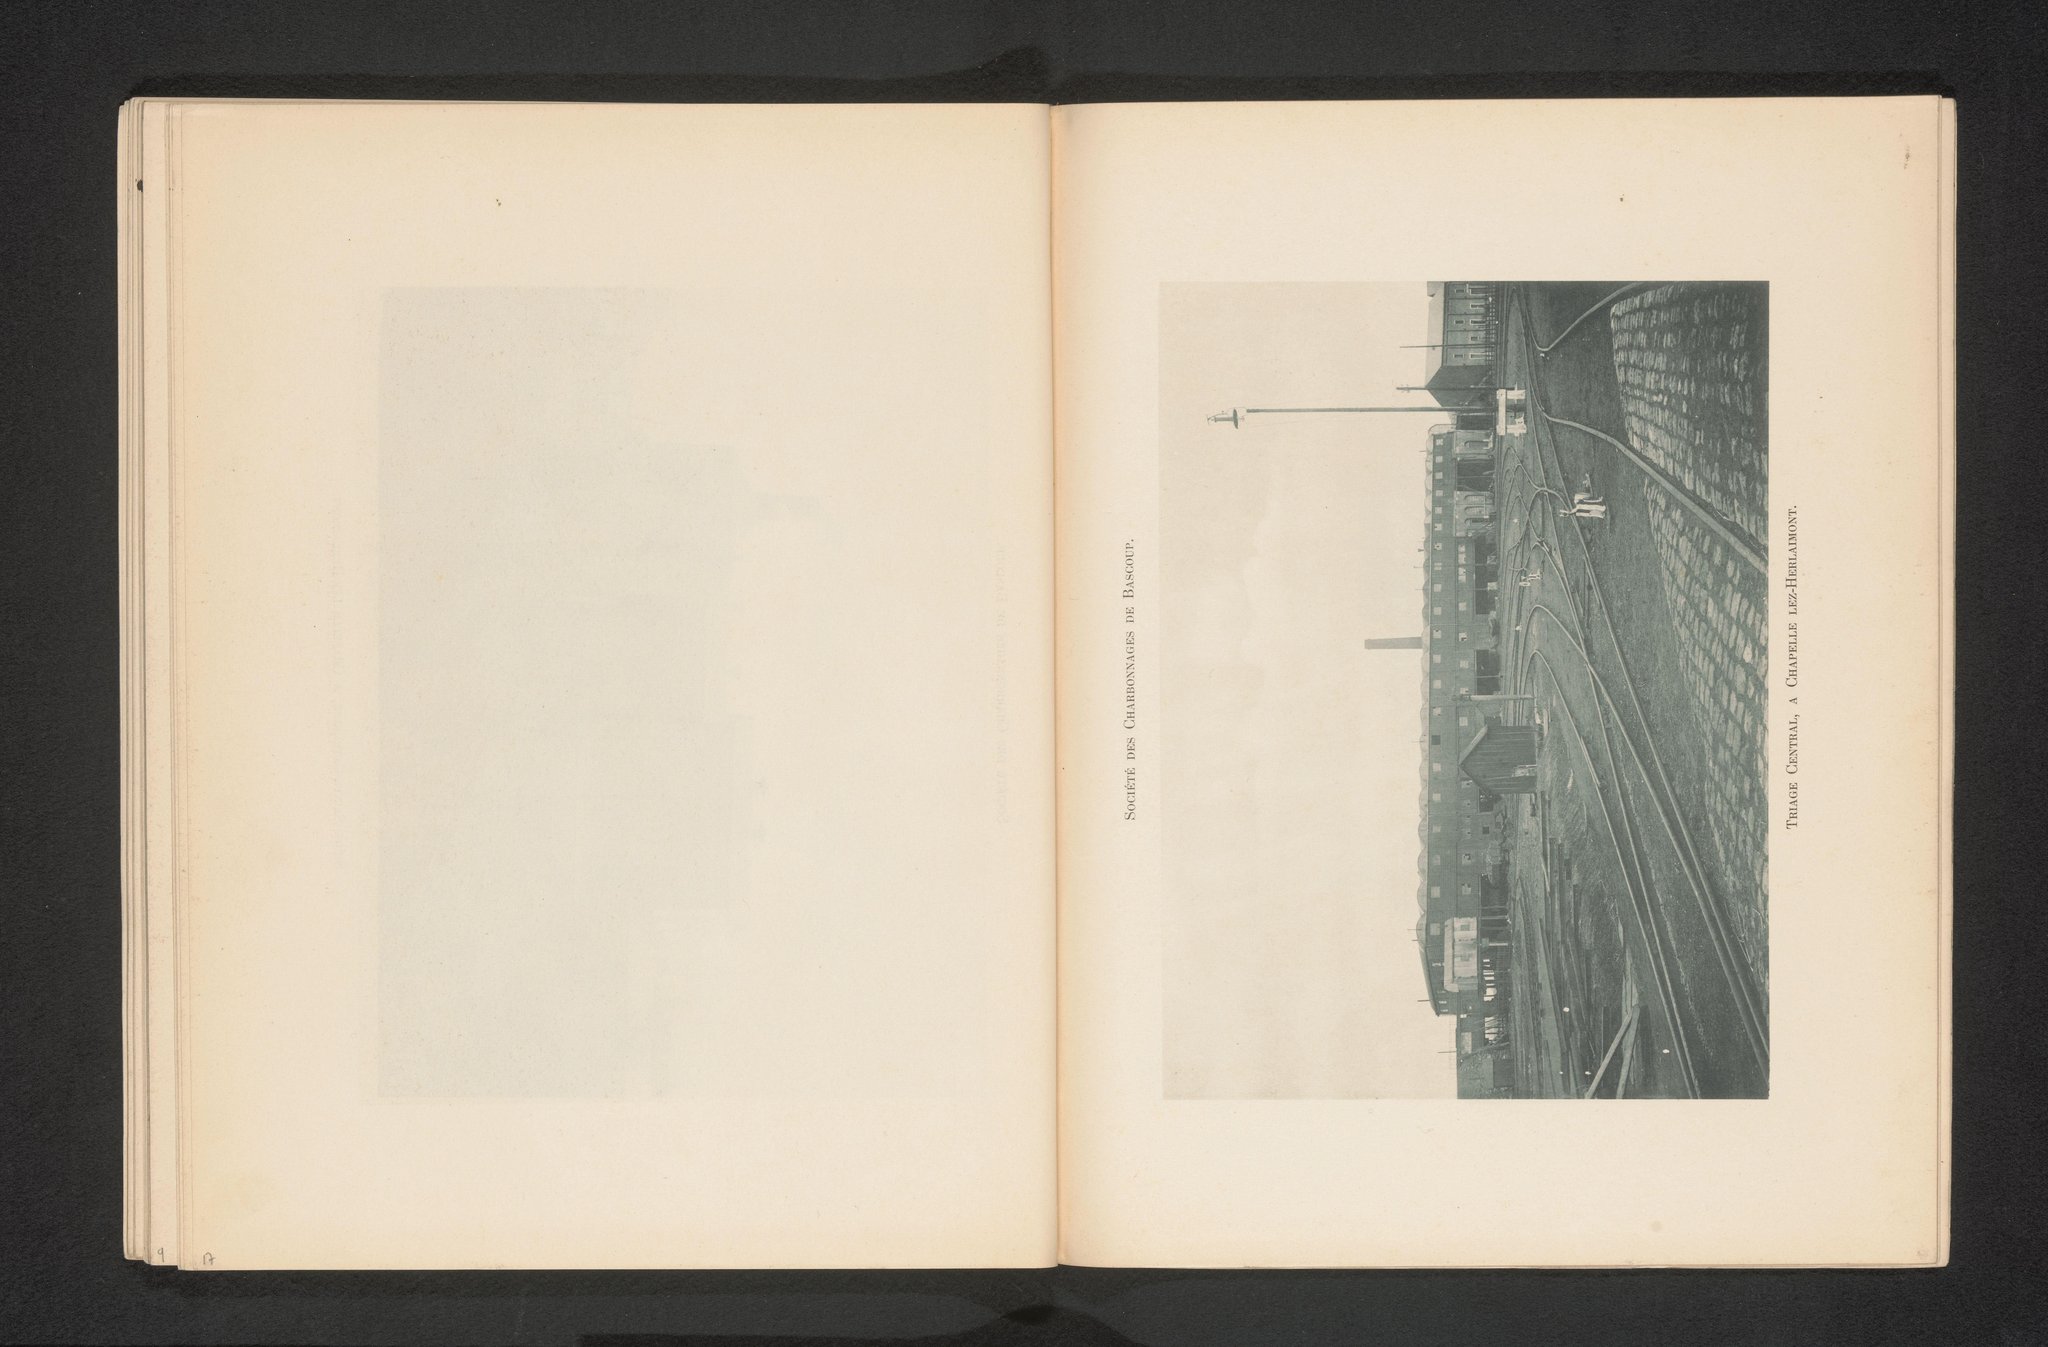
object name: photomechanical print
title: Gezicht op de werkplaats van de steenkolenmijn te Chapelle lez-Herlaimont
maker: Anonymous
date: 1895-1900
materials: paper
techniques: photograph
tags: factory in landscape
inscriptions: inscription: ‘Société des Charbonnages de Mariemont’